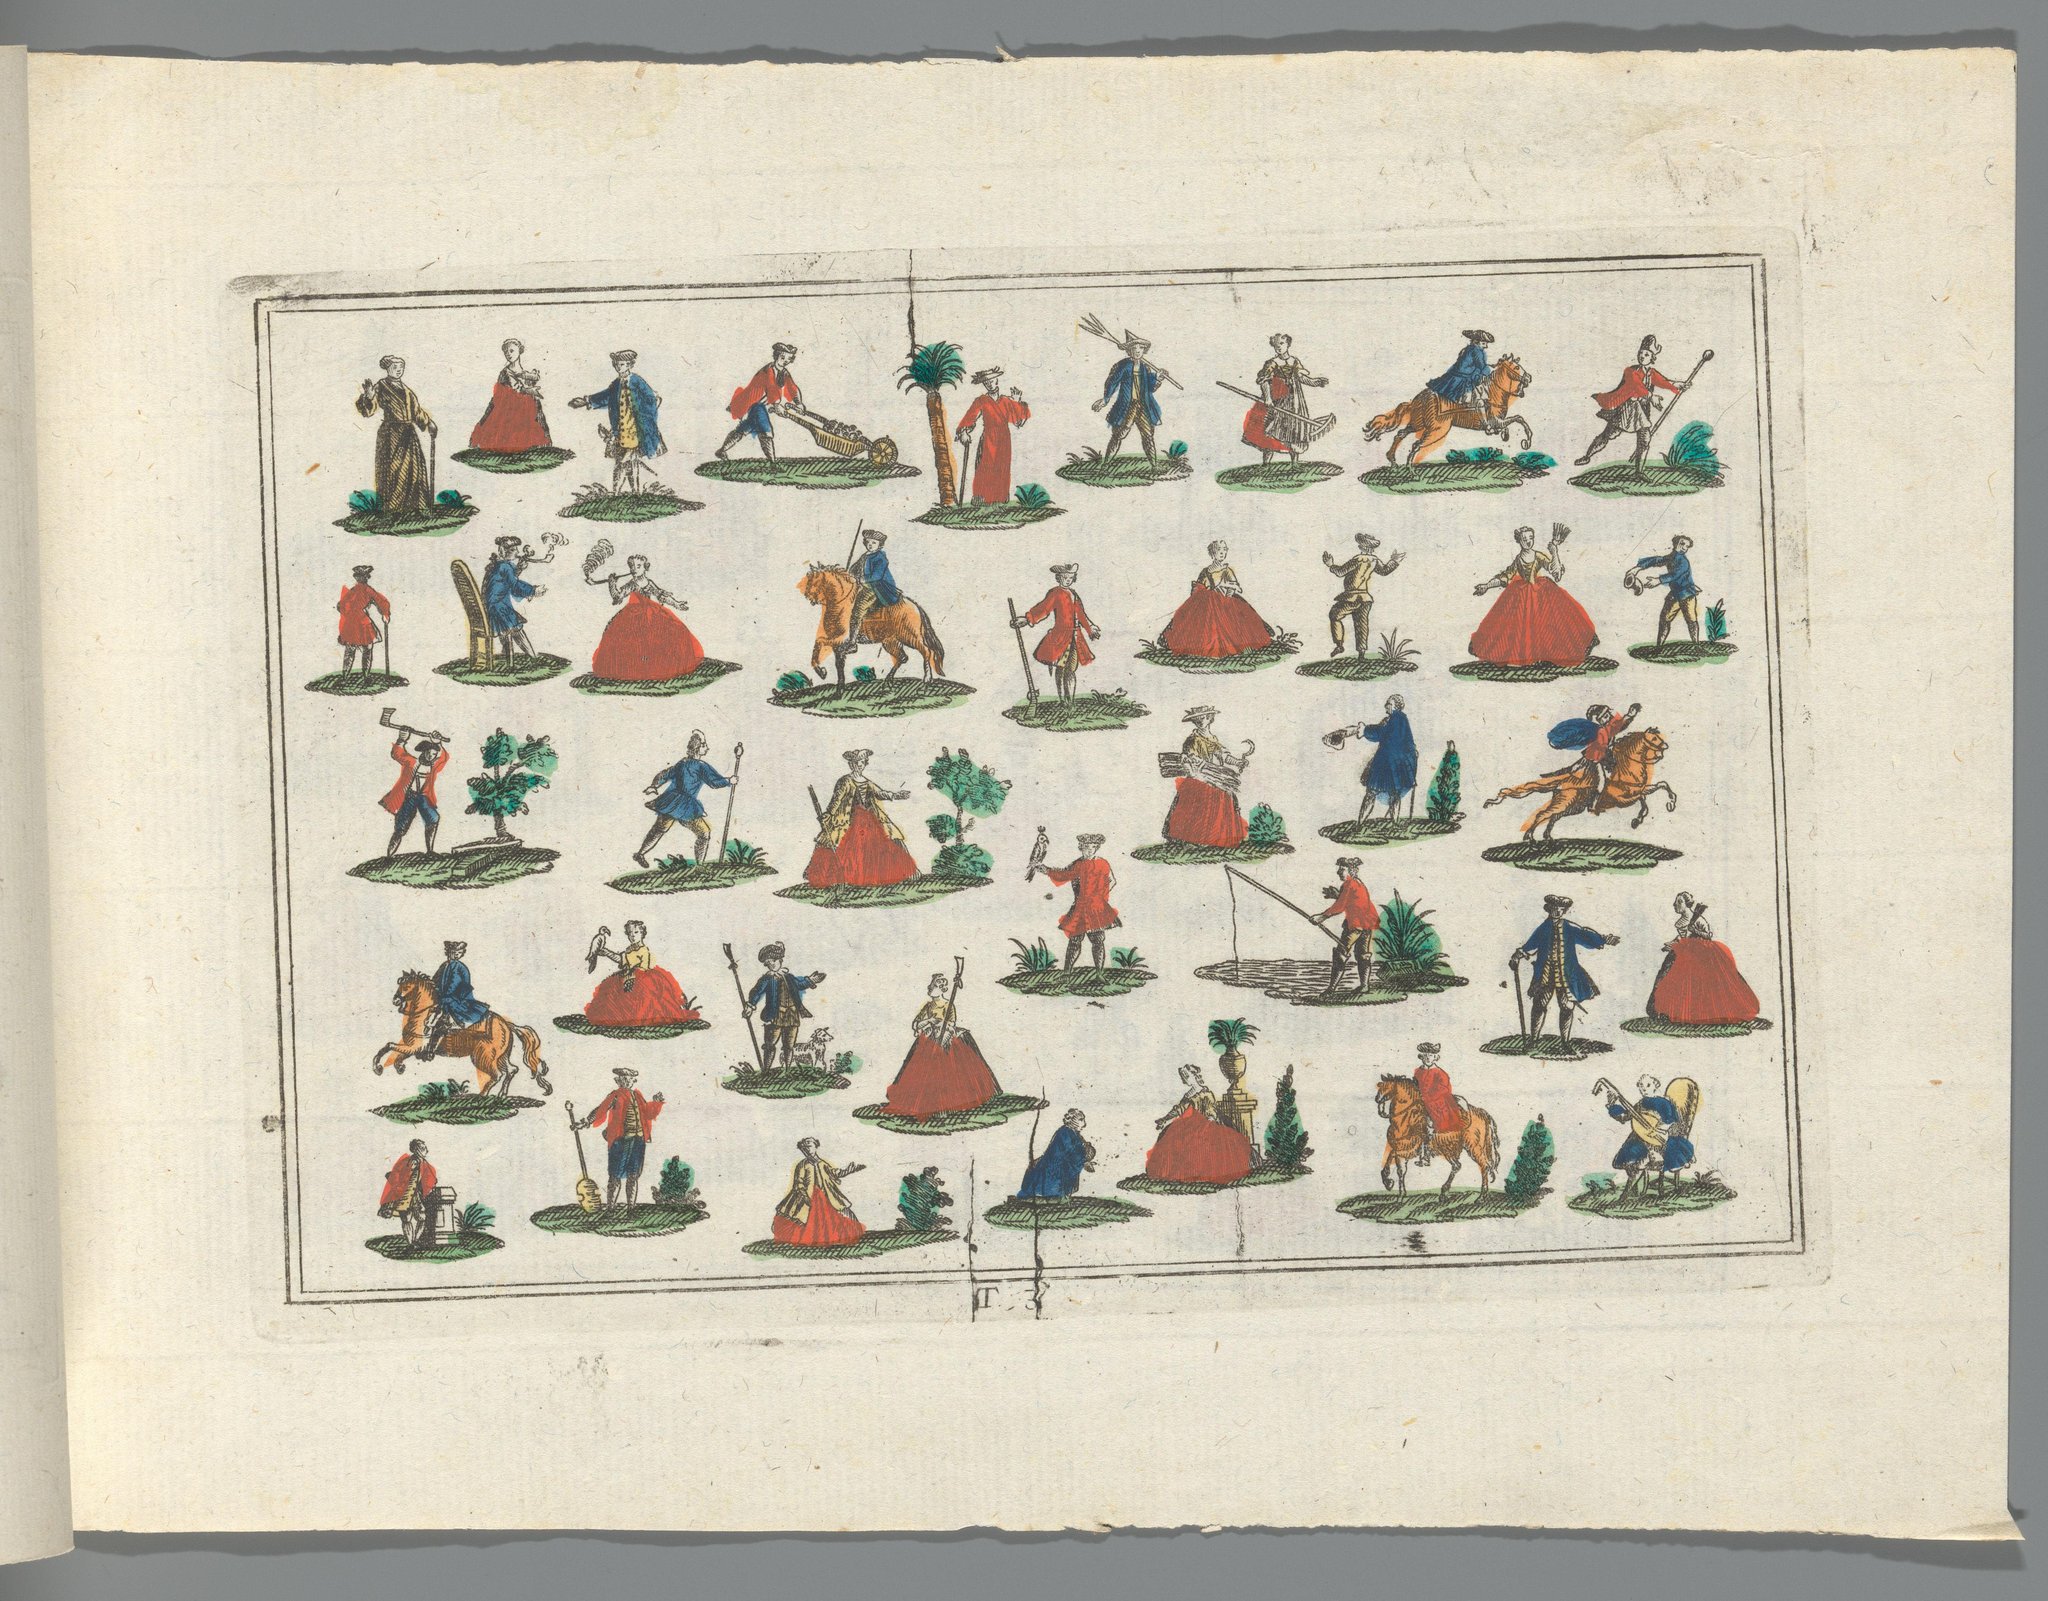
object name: print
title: Dames en heren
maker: Anonymous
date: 1750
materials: paper, watercolor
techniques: etching, hand coloring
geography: paris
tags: adult woman, adult man, clothes, costume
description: Blad met galante dames en heren, in verschillende bezigheden. Midden onder genummerd: T. 3. Een van 39 bladen met knipplaatjes en decoratieve randen.